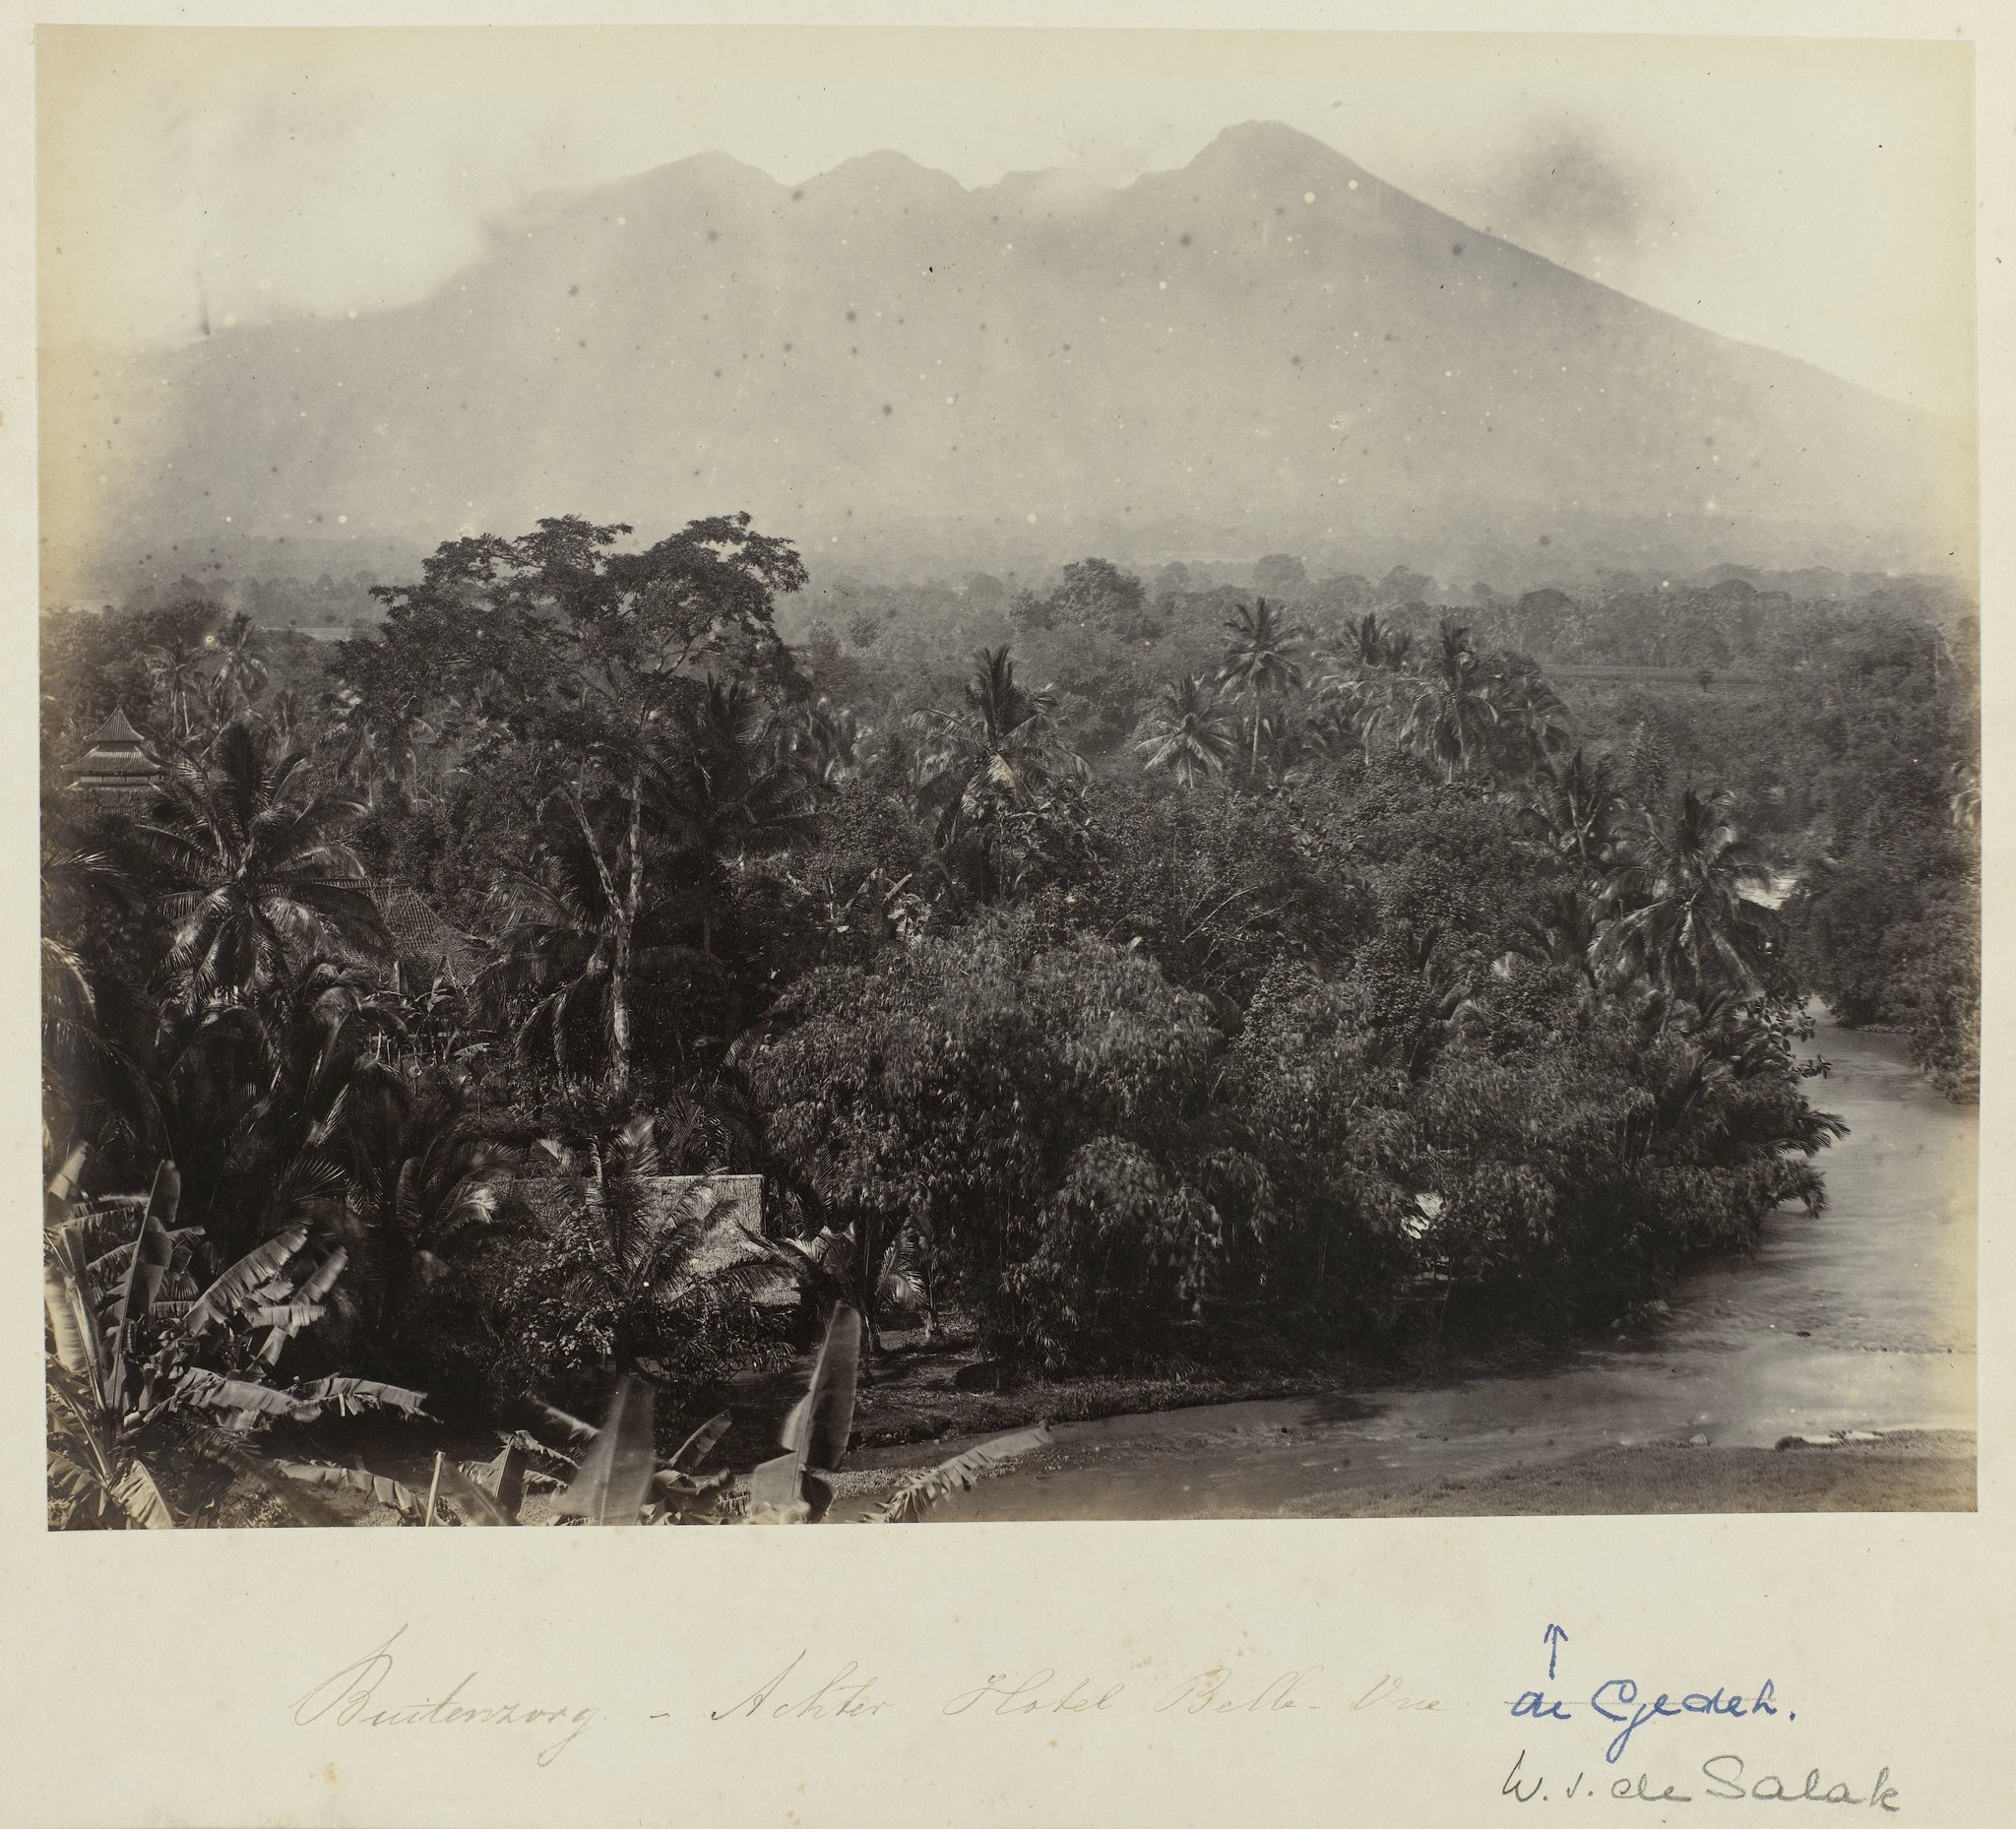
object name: photograph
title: Buitenzorg - Achter Hotel Belle-Vue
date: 1863-1869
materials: photographic support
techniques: albumen print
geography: buitenzorg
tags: jungle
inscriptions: inscription: ‘Buitenzorg - Achter Hotel Belle-Vue’, inscription: ‘de Gedeh / W.r. de Salak’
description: Gezicht op boslandschap met rivier gelegen achter Hotel Belle-Vue in Buitenzorg. In de verte de berg Gunung Salak Satu. Onderdeel van het groene fotoalbum met foto's van Java, uit het bezit van apotheker Specht-Grijp, die in 1865 vanuit Batavia naar Nederland terugkeerde.